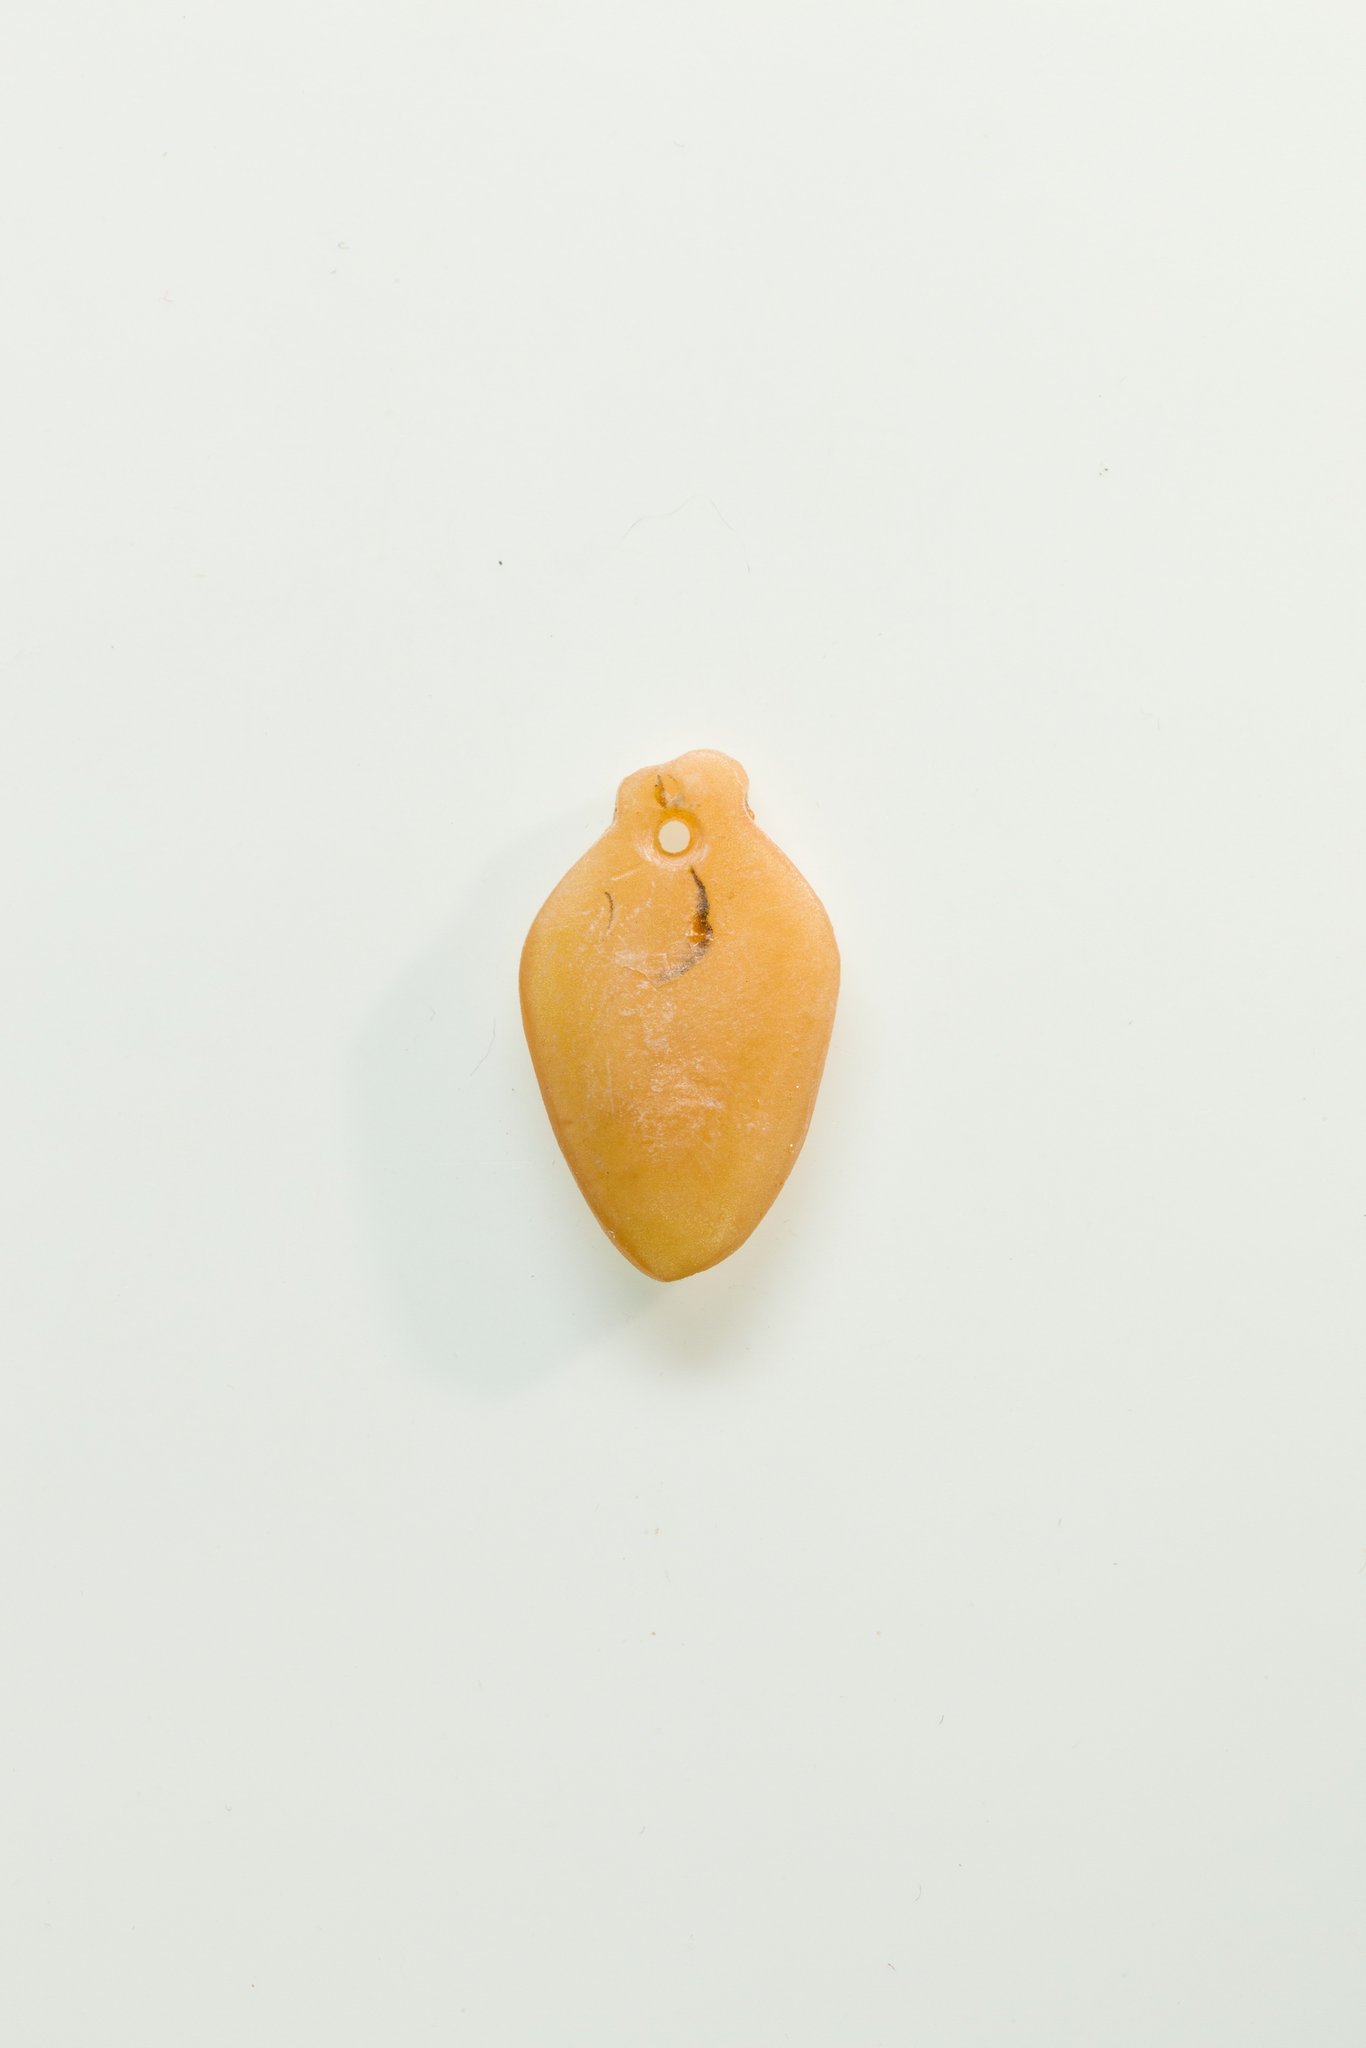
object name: ib heart amulet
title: Heart (ib) from string of amulets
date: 1070-945 BCE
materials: gemstone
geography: egypt